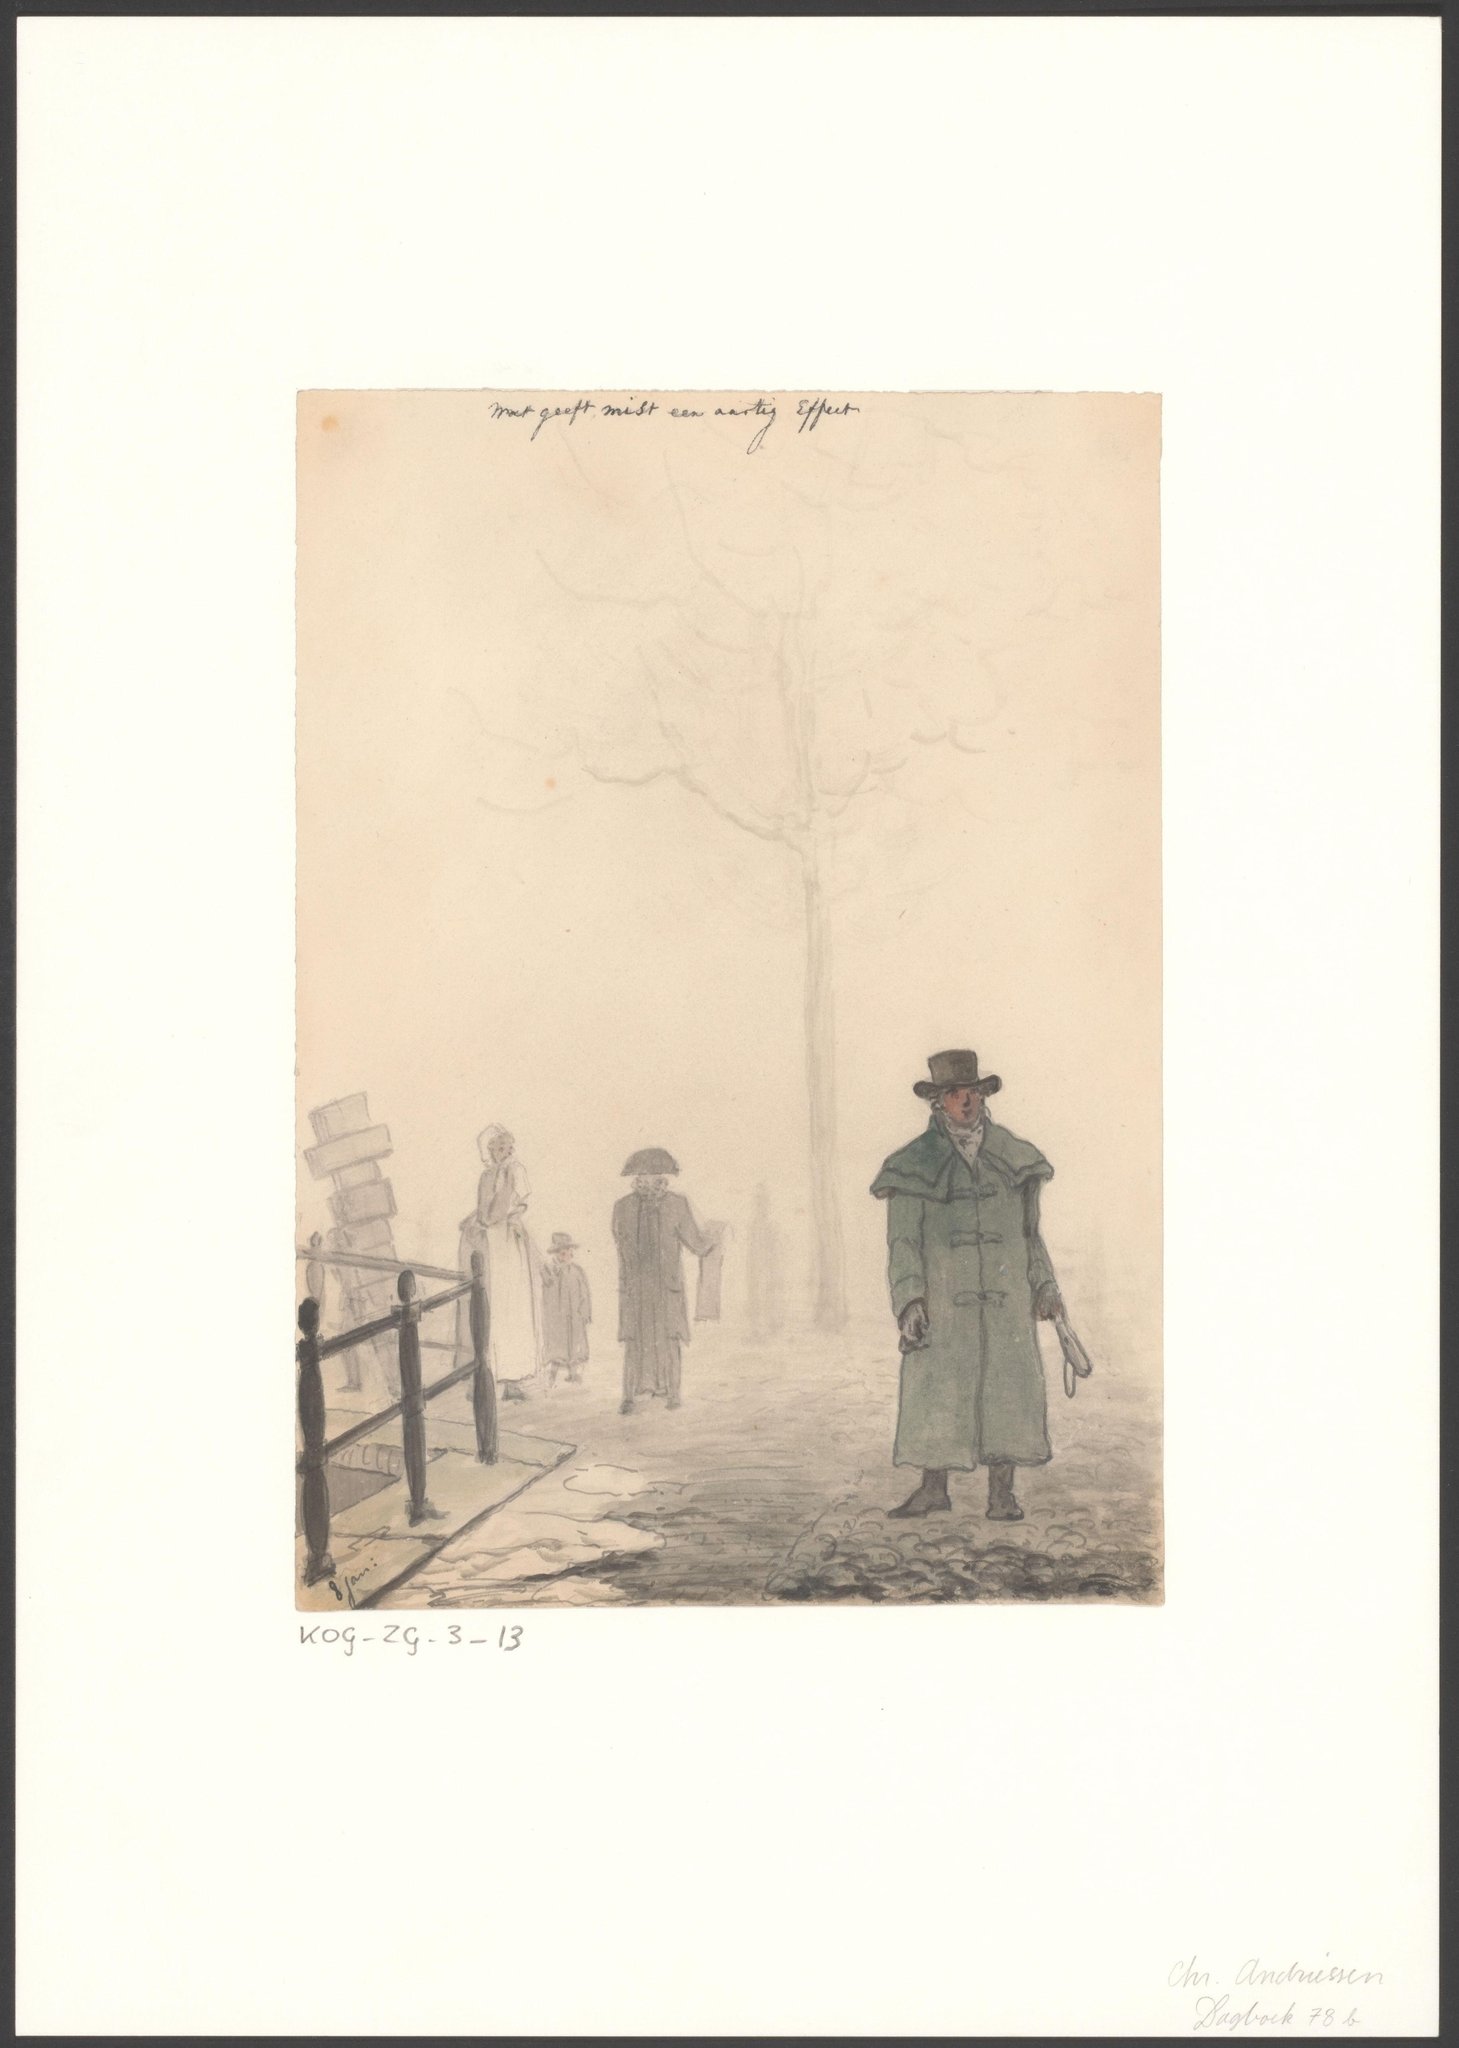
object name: drawing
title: Man in de mist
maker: christiaan andriessen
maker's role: draughtsman, print maker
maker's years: 1775-1846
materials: ink, paper, pencil, watercolor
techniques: pen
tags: public gardens, park, mist, fog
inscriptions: inscription: ‘8 jan: wat geeft mist een aartig effect’, inscription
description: Dagboekblad uit het getekende dagboek dat Christiaan Andriessen bijhield van 1805 tot en met 1808.